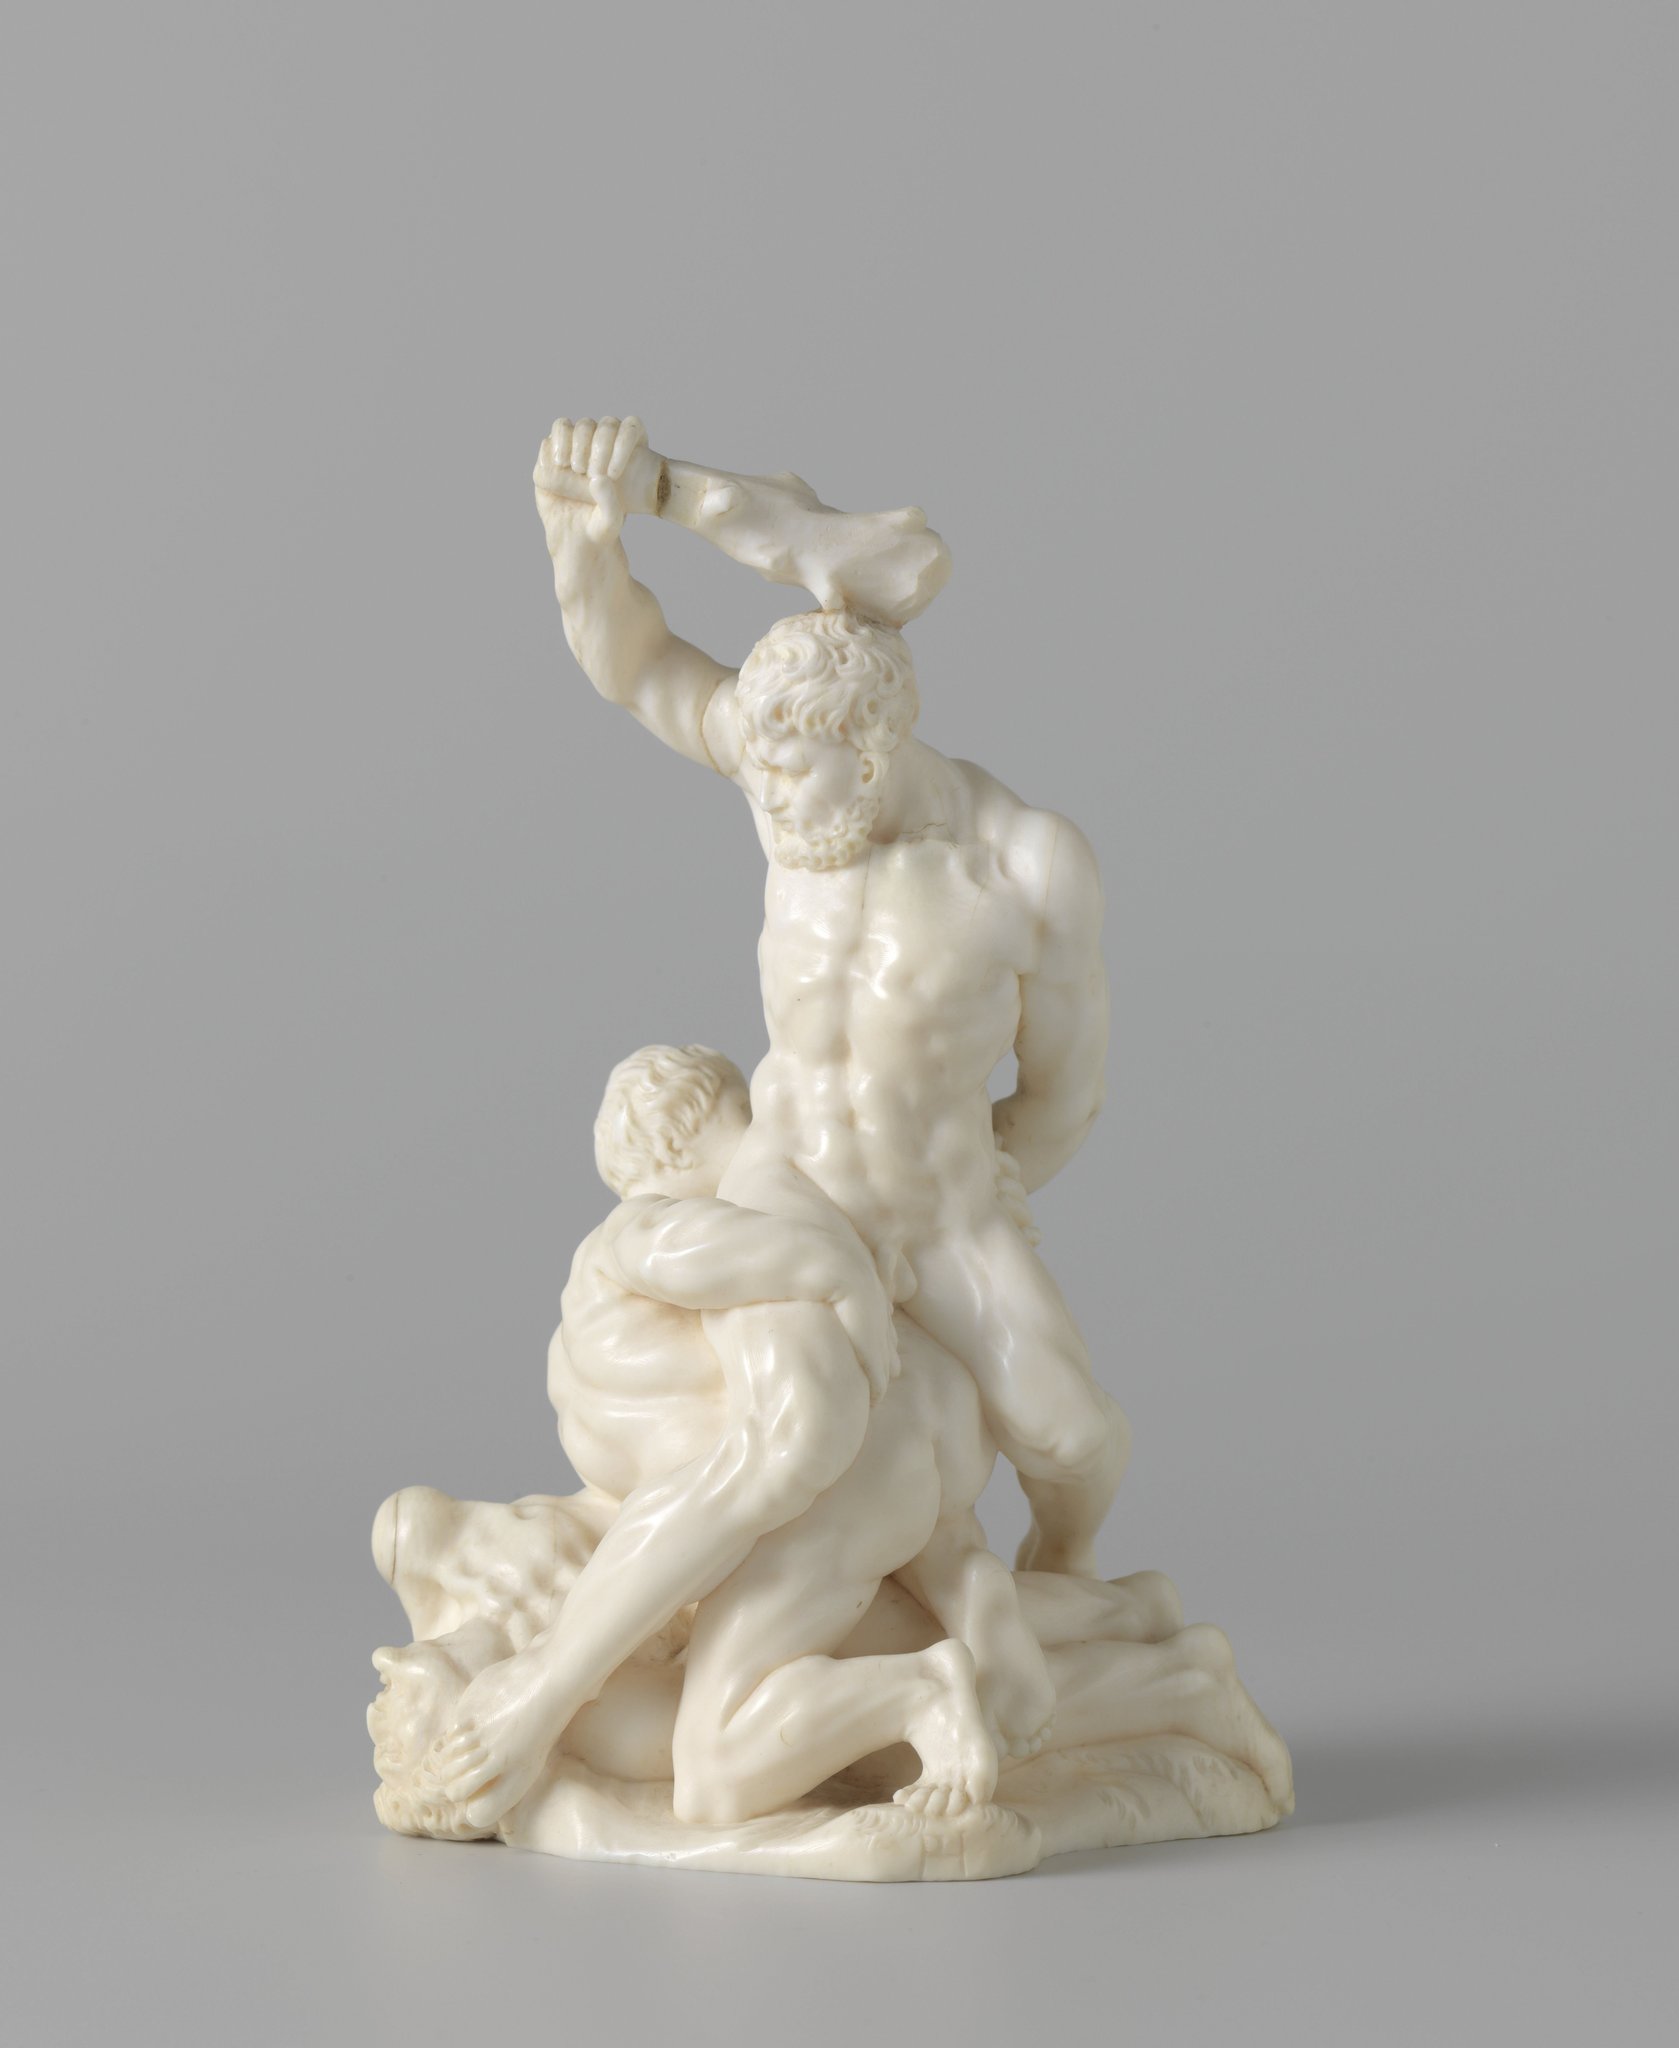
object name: sculpture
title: Samson Fighting Two Philistines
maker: paul heermann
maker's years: 1673-1732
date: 1700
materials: ivory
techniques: cutting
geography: dresden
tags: william i of the netherlands, samson in conflict with the philistines (judges 15:1-8)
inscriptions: signature: ‘PH’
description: The Saxon court sculptor Paul Heermann spent a considerable period working in Italy. His sojourn there doubtless accounts for the realization of this ivory. The composition is a copy of a lost original design by Michelangelo, the popularity of which is evident from the number of small bronze versions of the subject.